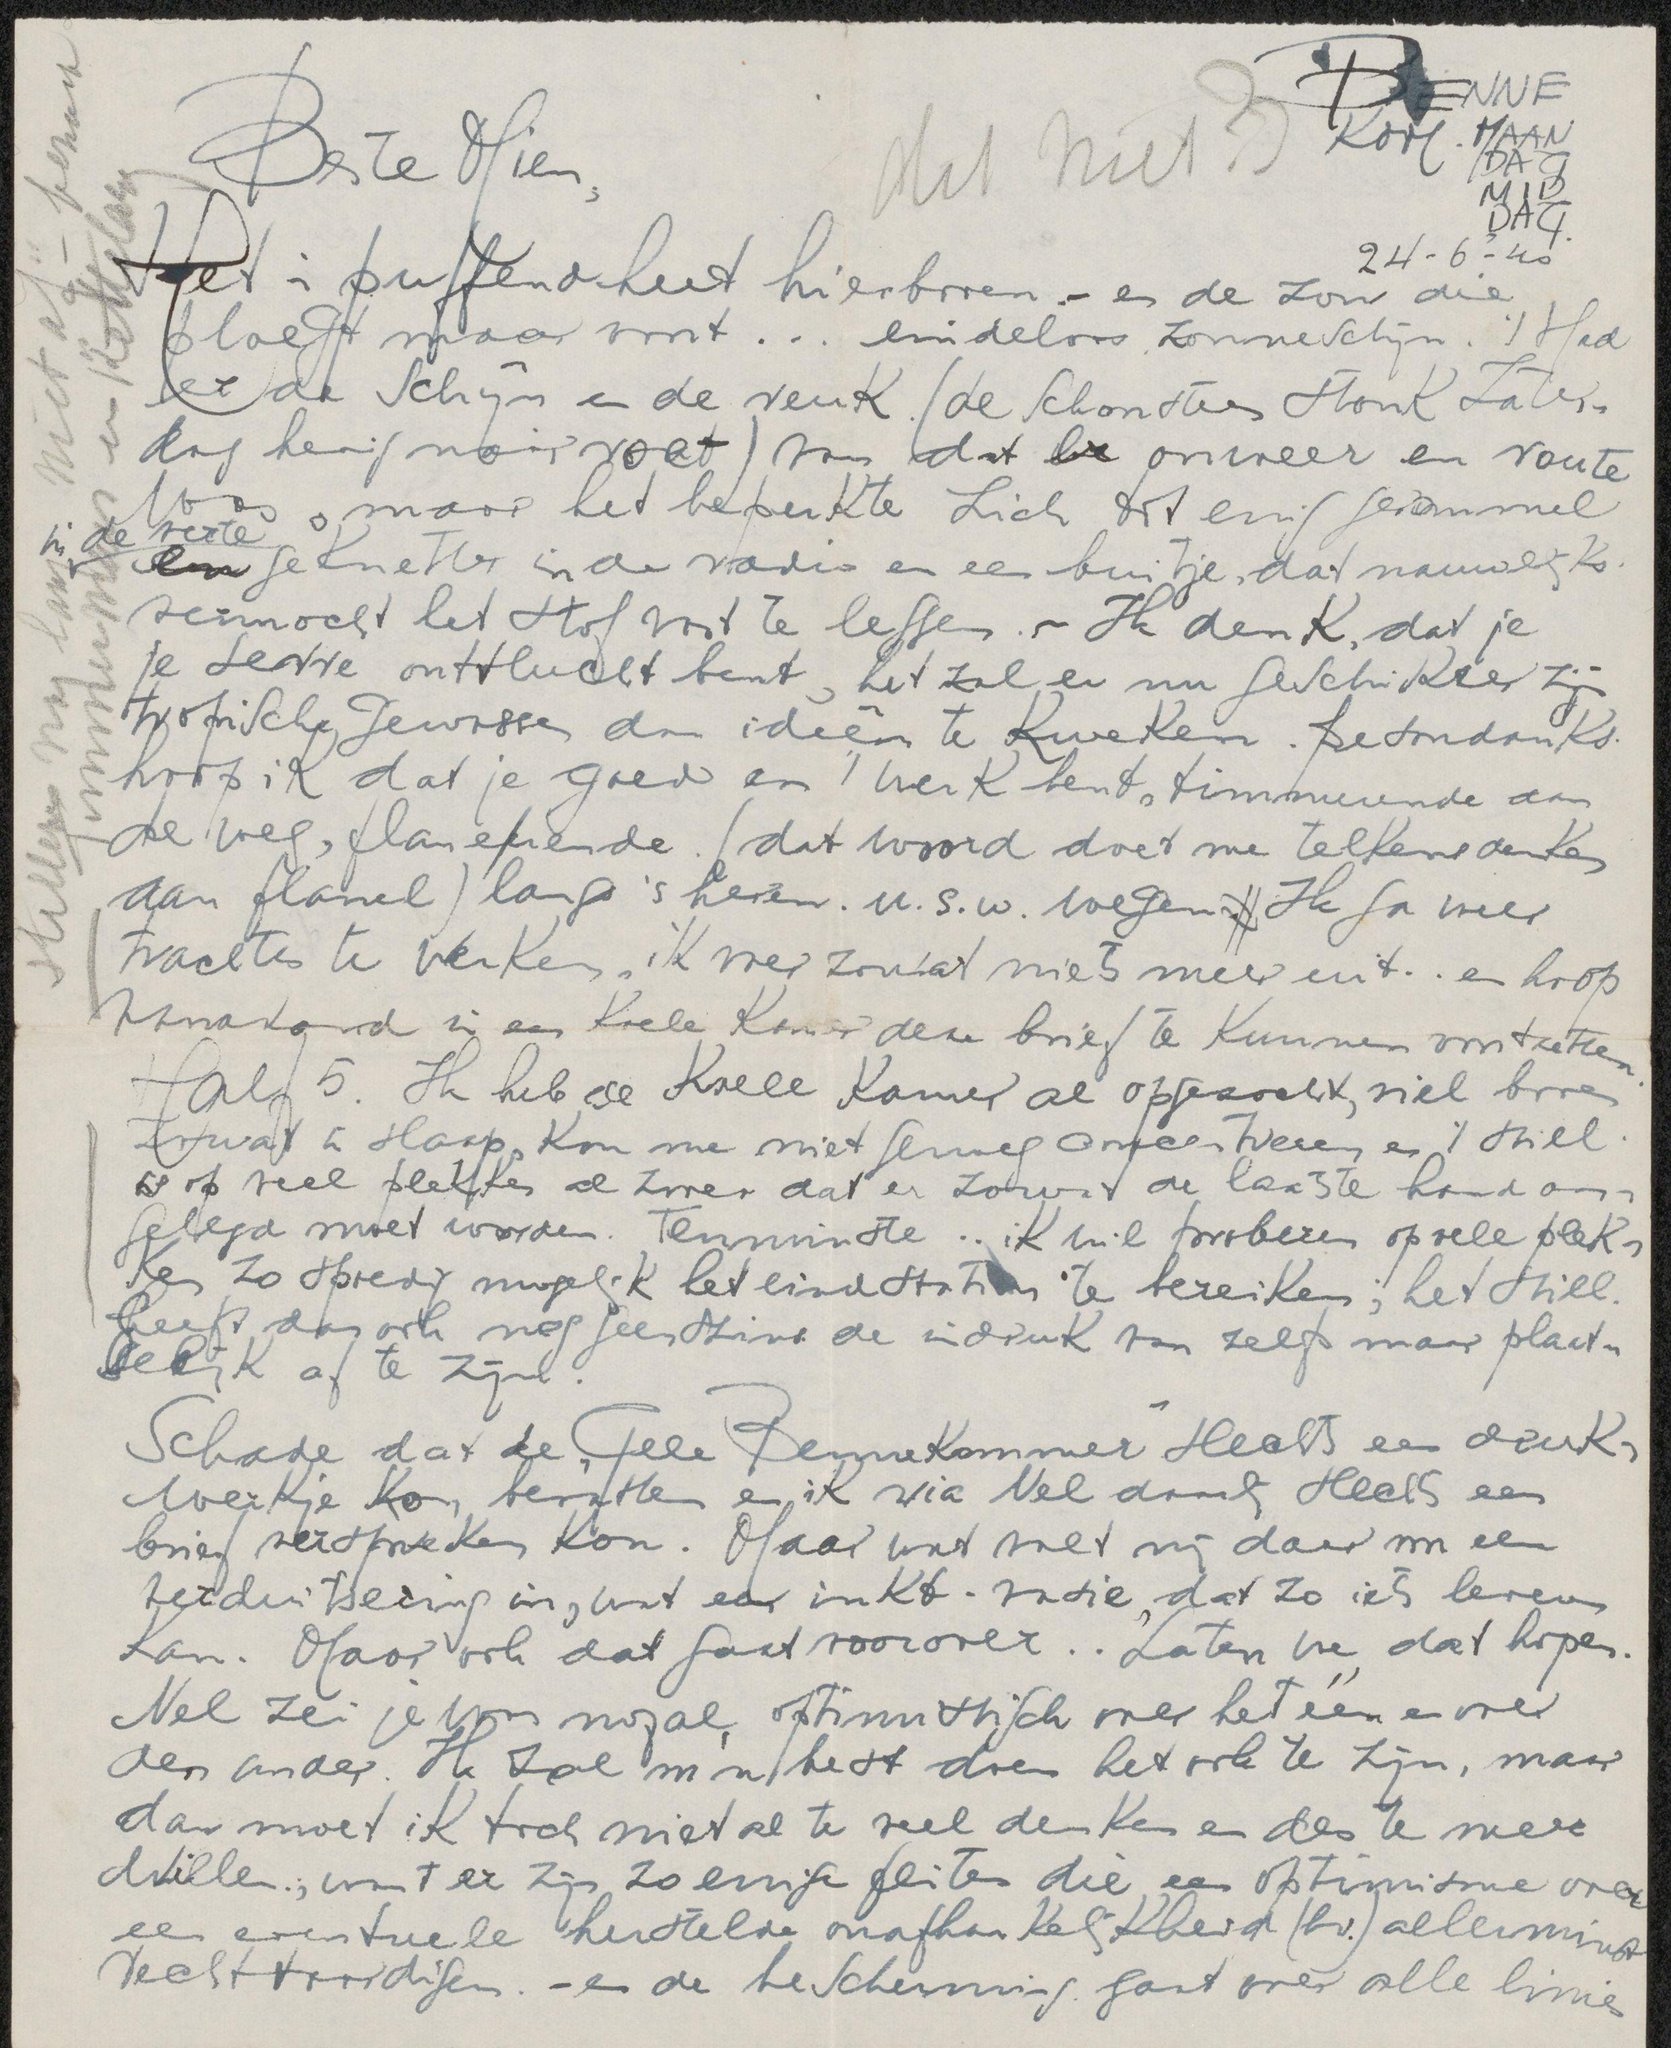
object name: letter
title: Brief aan Mien Cambier van Nooten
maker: dick ket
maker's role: draughtsman, print maker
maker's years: 1902-1940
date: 1940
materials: ink, paper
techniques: pen, writing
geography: bennekom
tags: rotterdam, painter, print maker, hans timmermans, amsterdam, arnhem, mien cambier van nooten, haarlem, textile artist, nelly johanna hagelen-schilt, drawing, literature ~ arts